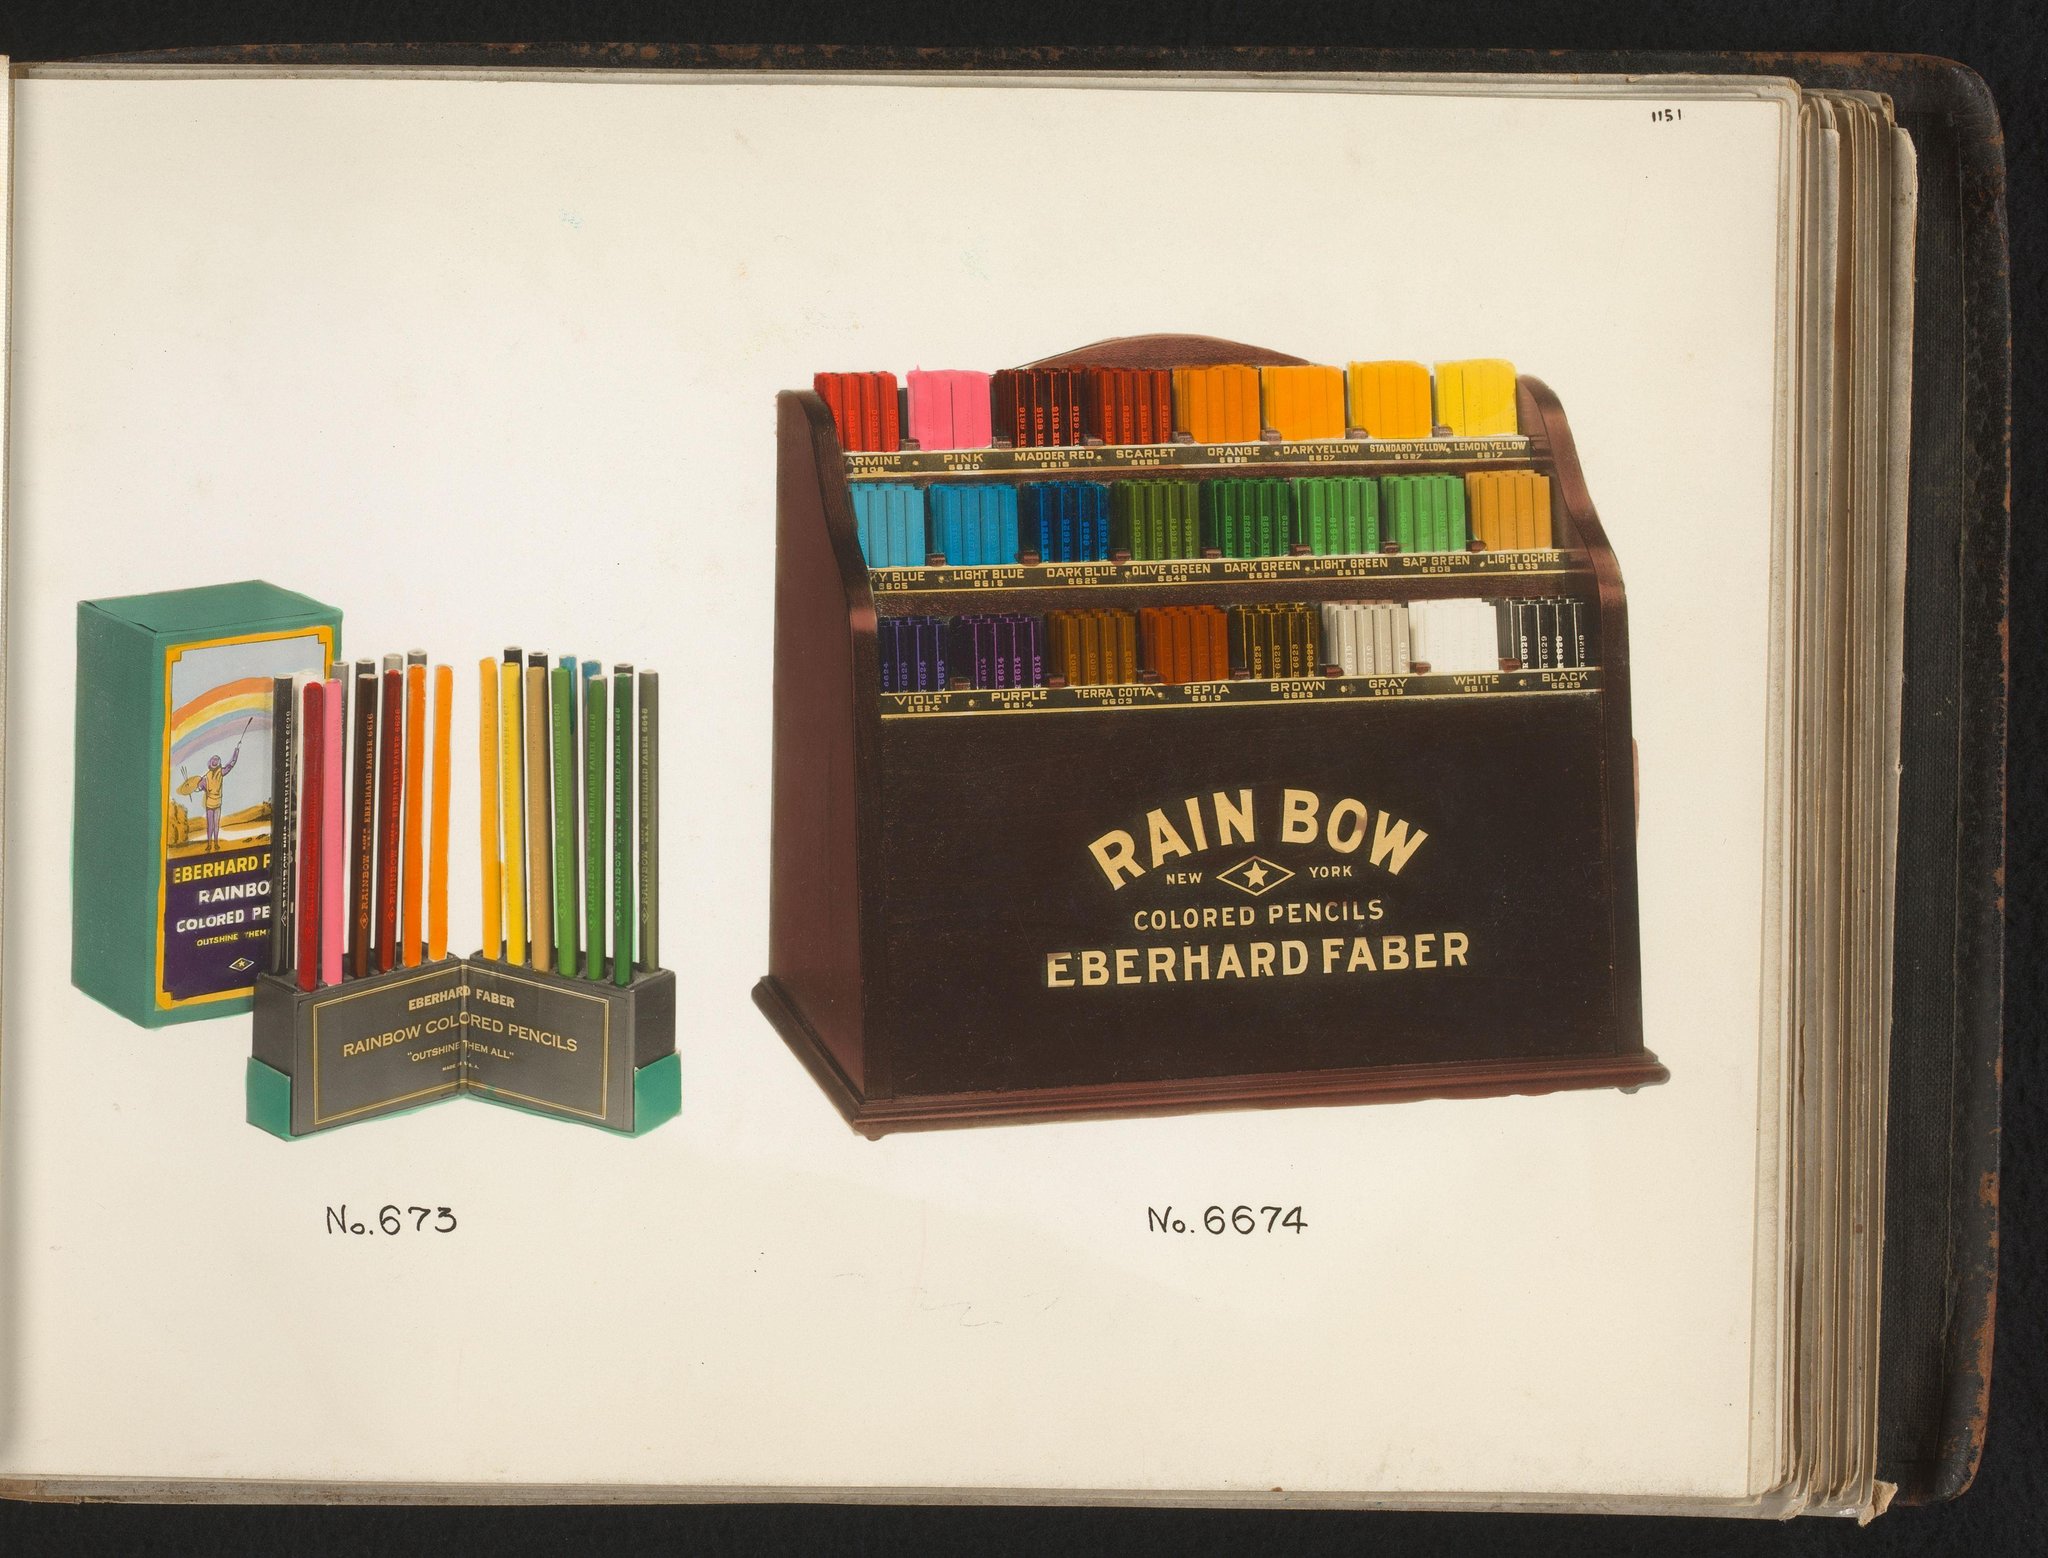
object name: album leaf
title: Sets met kleurpotloden van Eberhard Faber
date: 1915-1935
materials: paper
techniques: gelatin silver print, hand coloring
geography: springfield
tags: pencil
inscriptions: number: ‘1151’, stamp: ‘Paramount/ Commercial Studios/ 145 Chestnut St./ Springfield - Mass.’